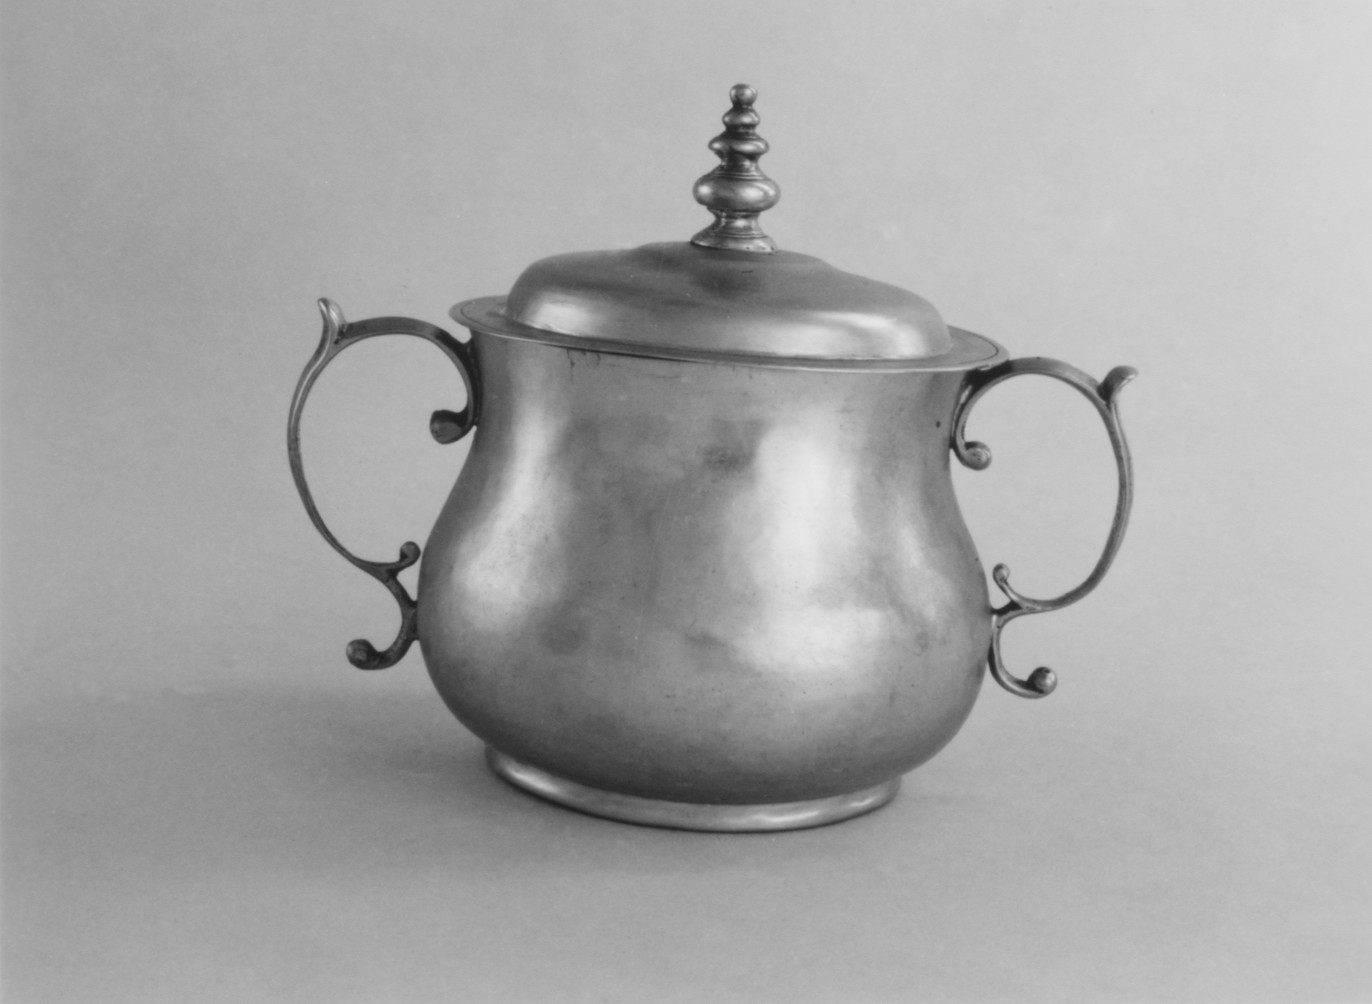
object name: cup with cover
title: Two-handled cup with cover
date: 1664-1665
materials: silver